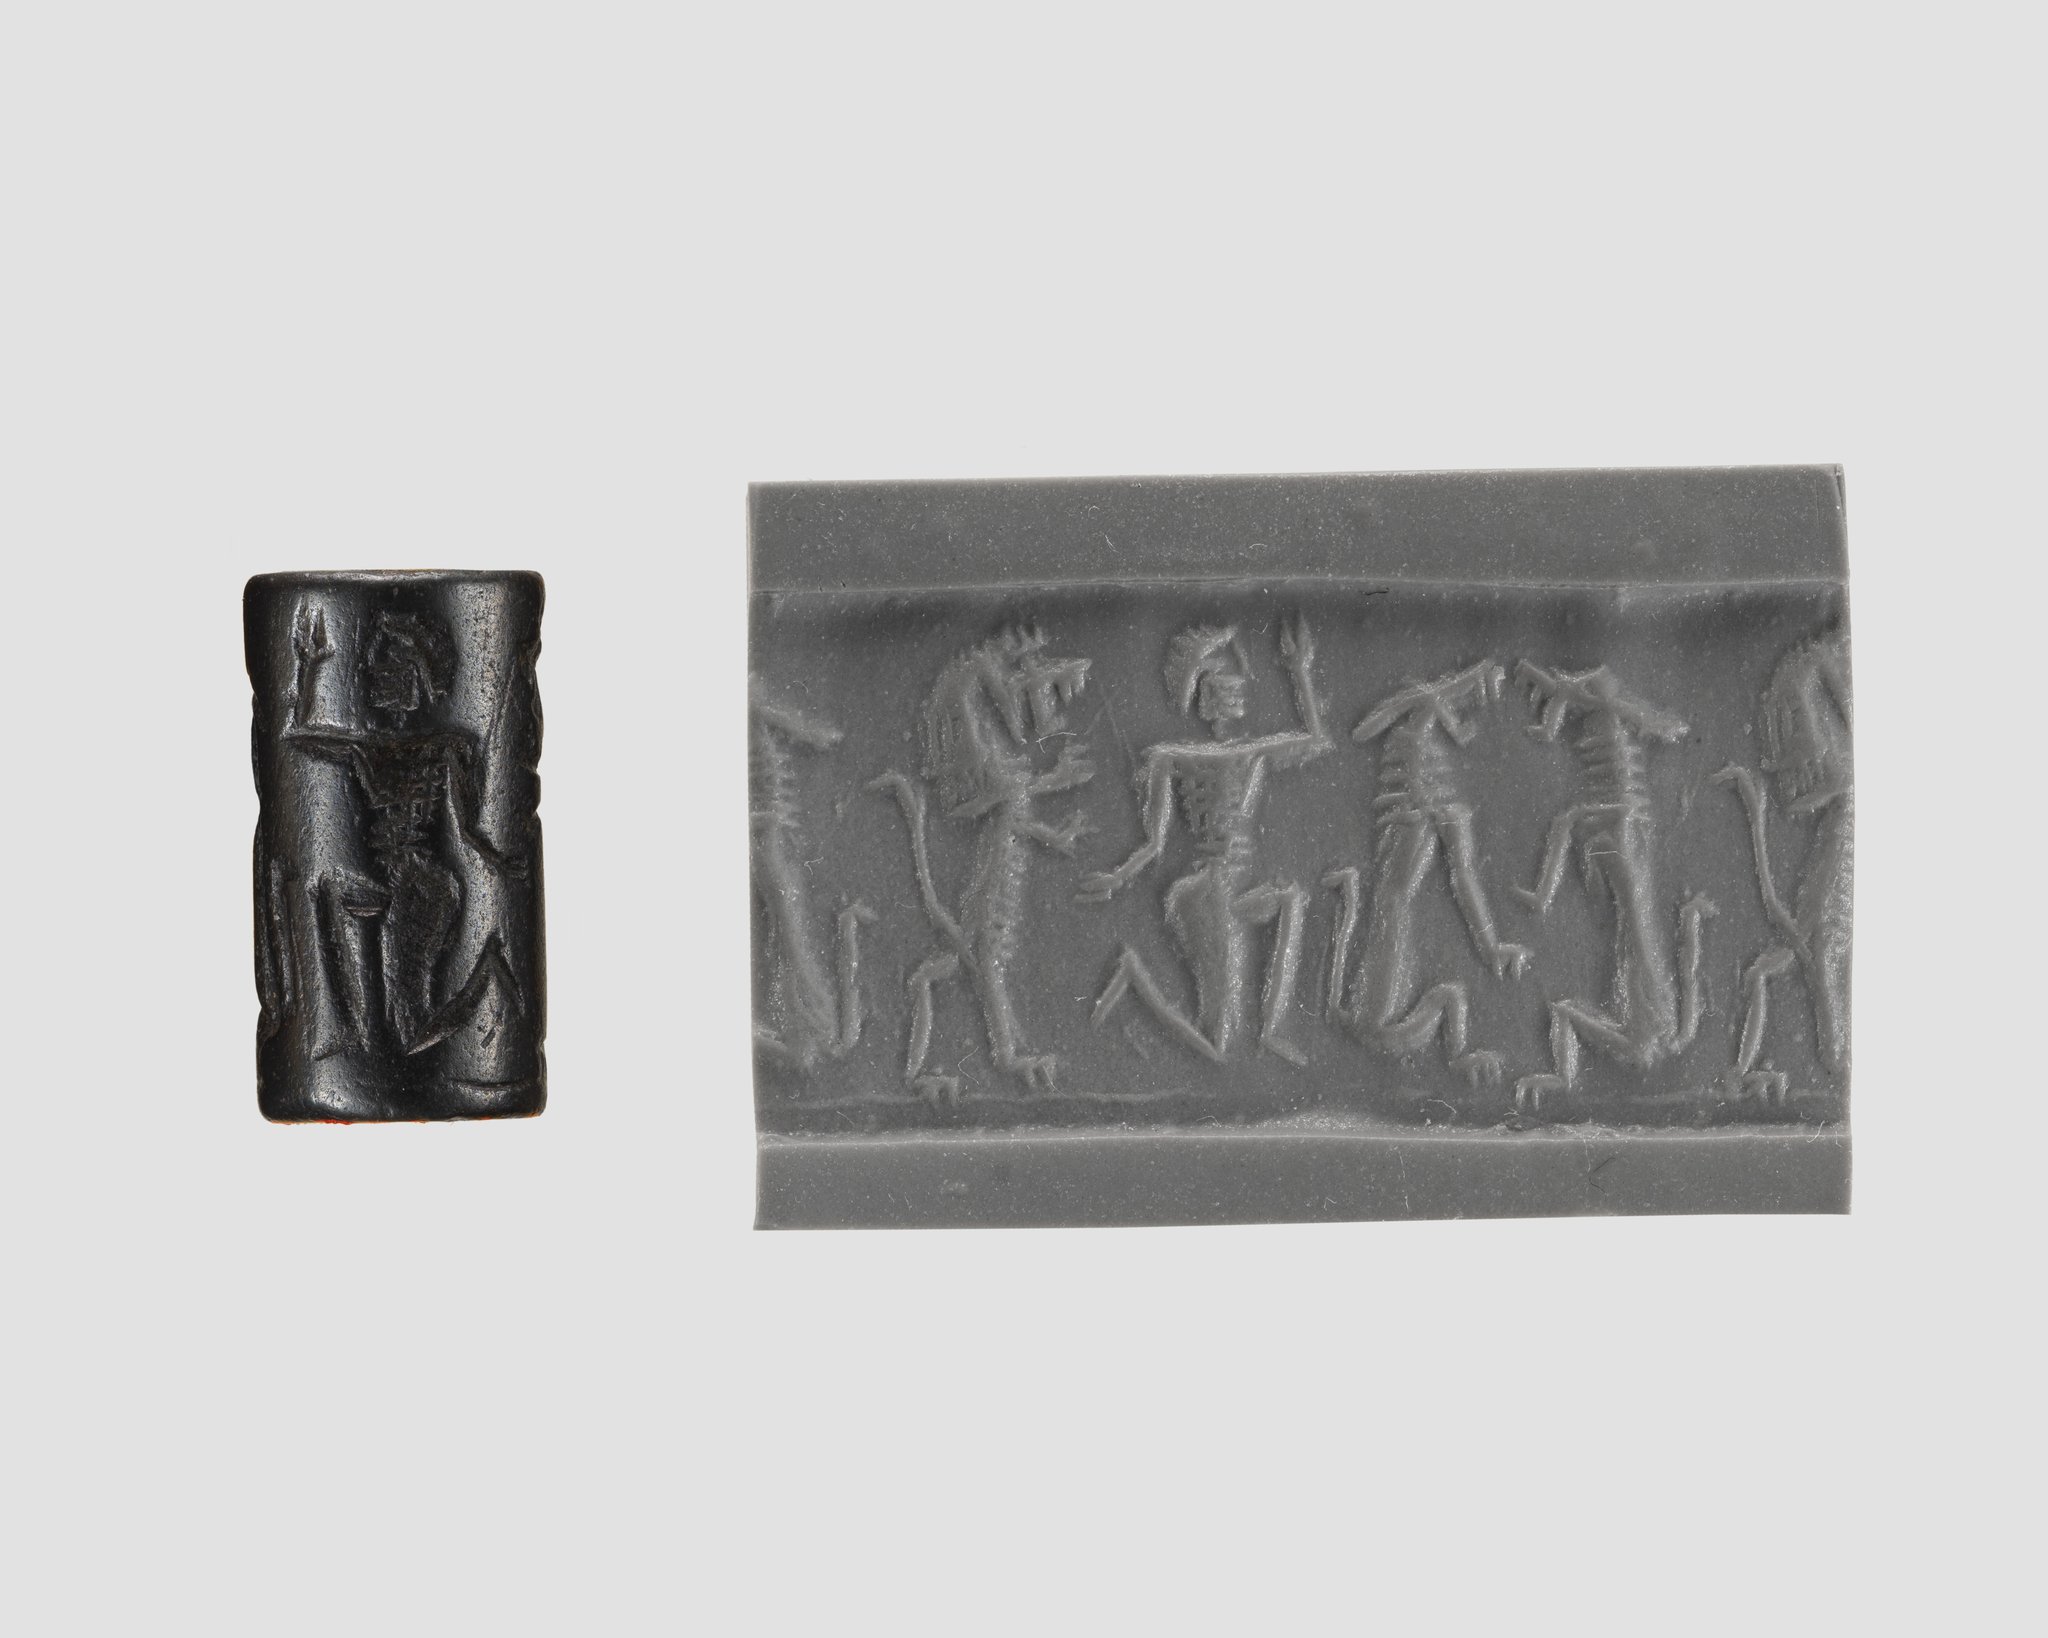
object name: cylinder seal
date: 1720-1650 BCE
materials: mineral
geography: syria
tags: lions